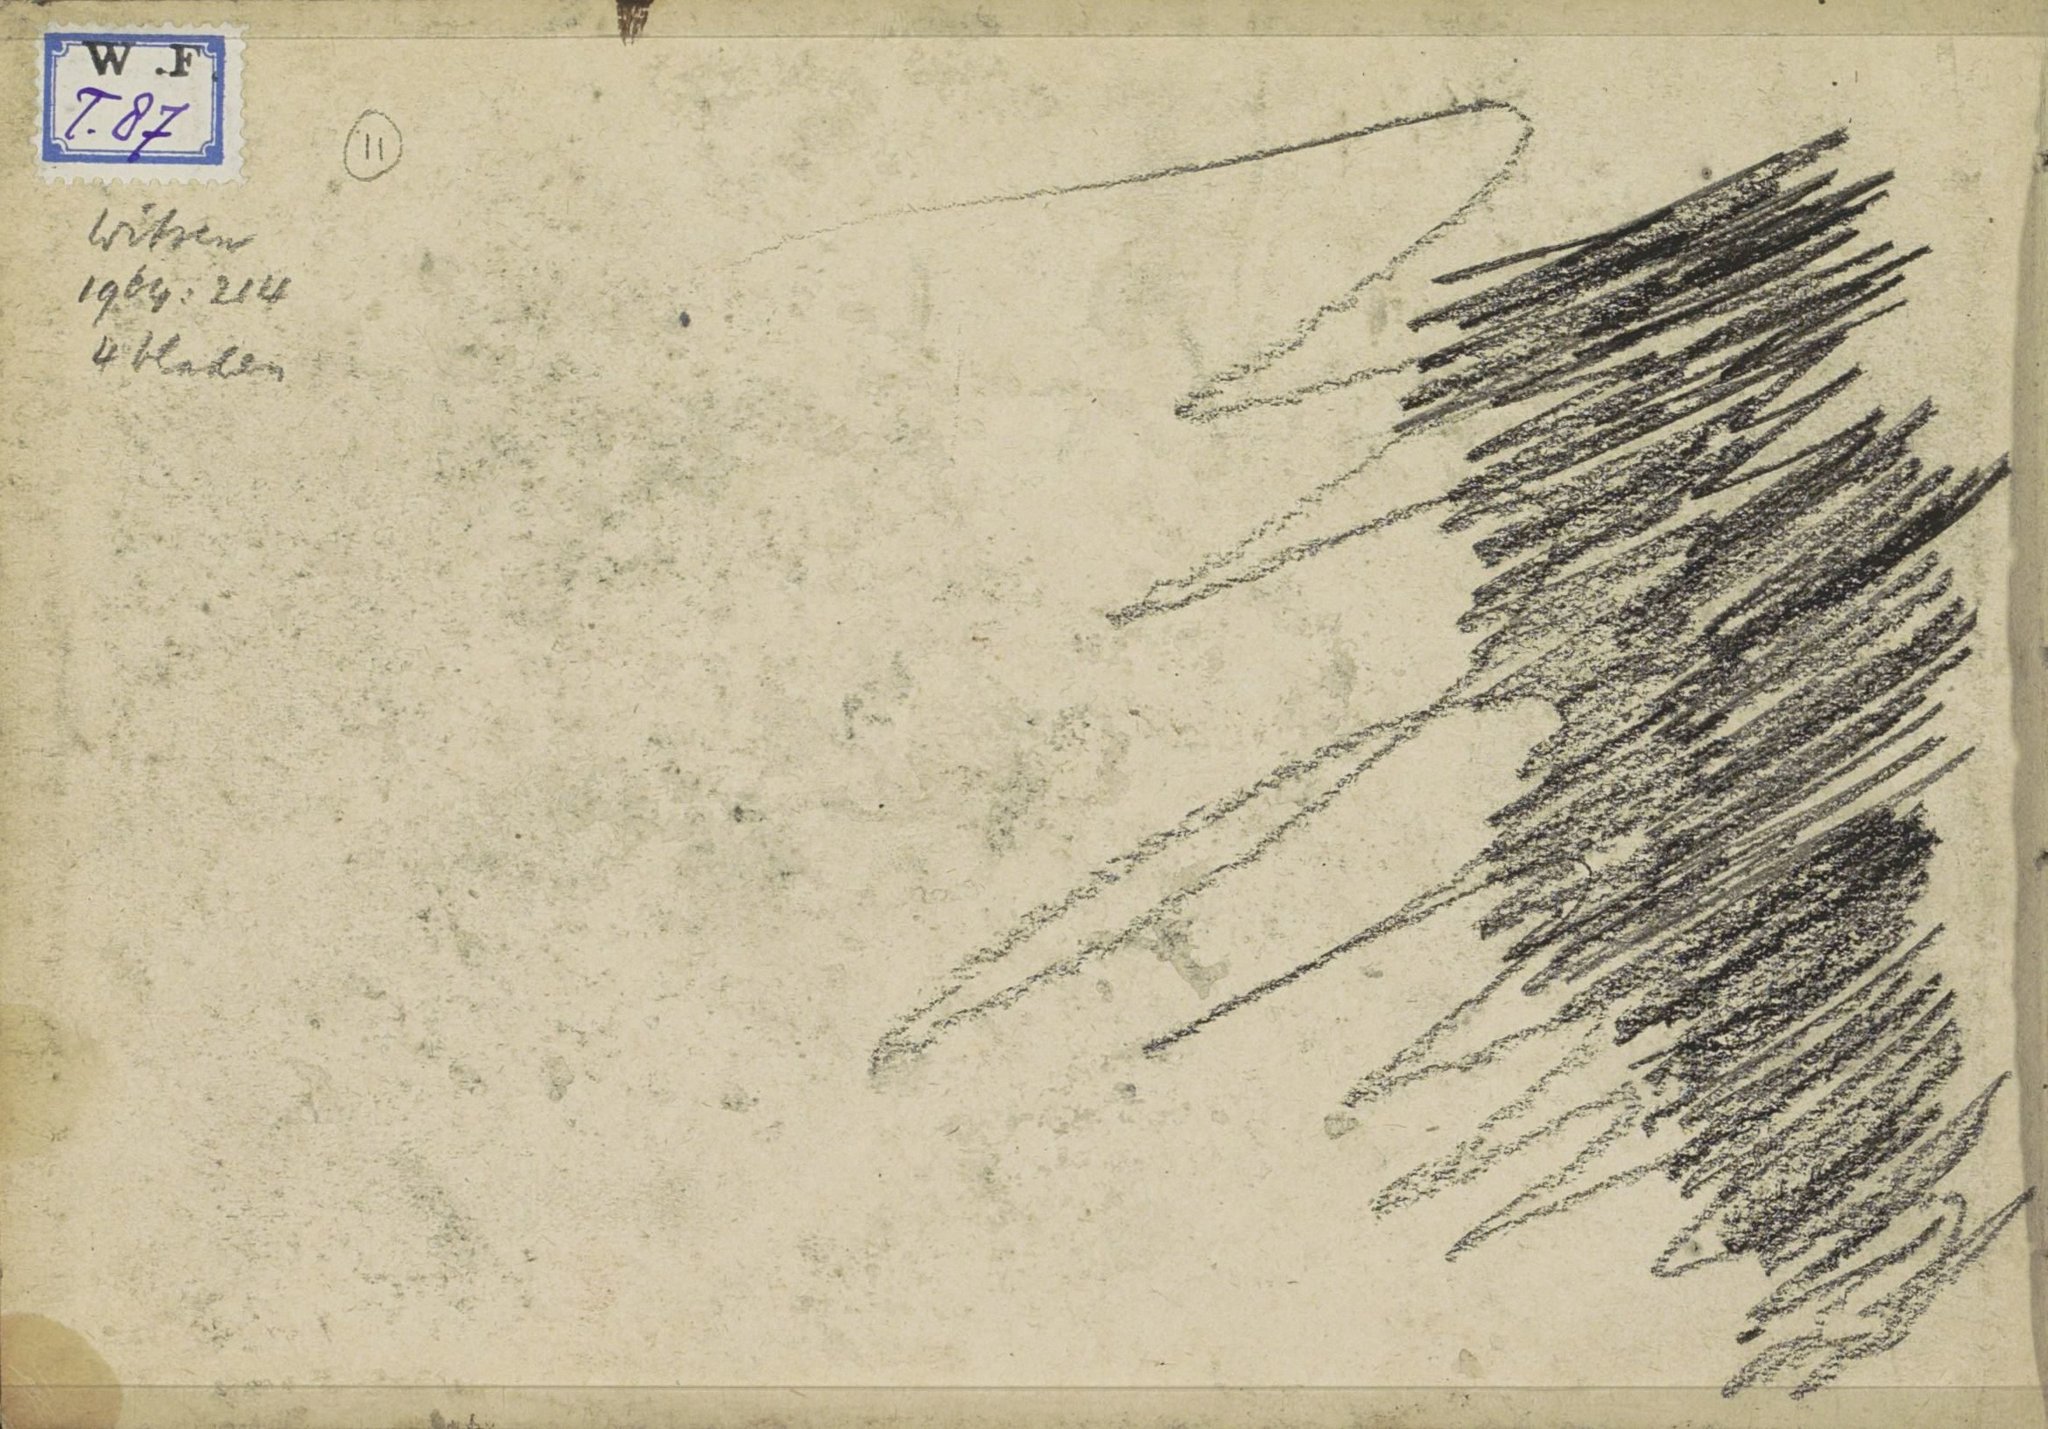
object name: endleaf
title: Studie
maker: willem witsen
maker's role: draughtsman, painter, print maker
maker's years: 1860-1923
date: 1875-1923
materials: chalk, paper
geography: netherlands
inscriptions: annotation: ‘W.F./ T. 87’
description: Schutblad A, voorste schutblad, uit een schetsboek met 4 bladen.